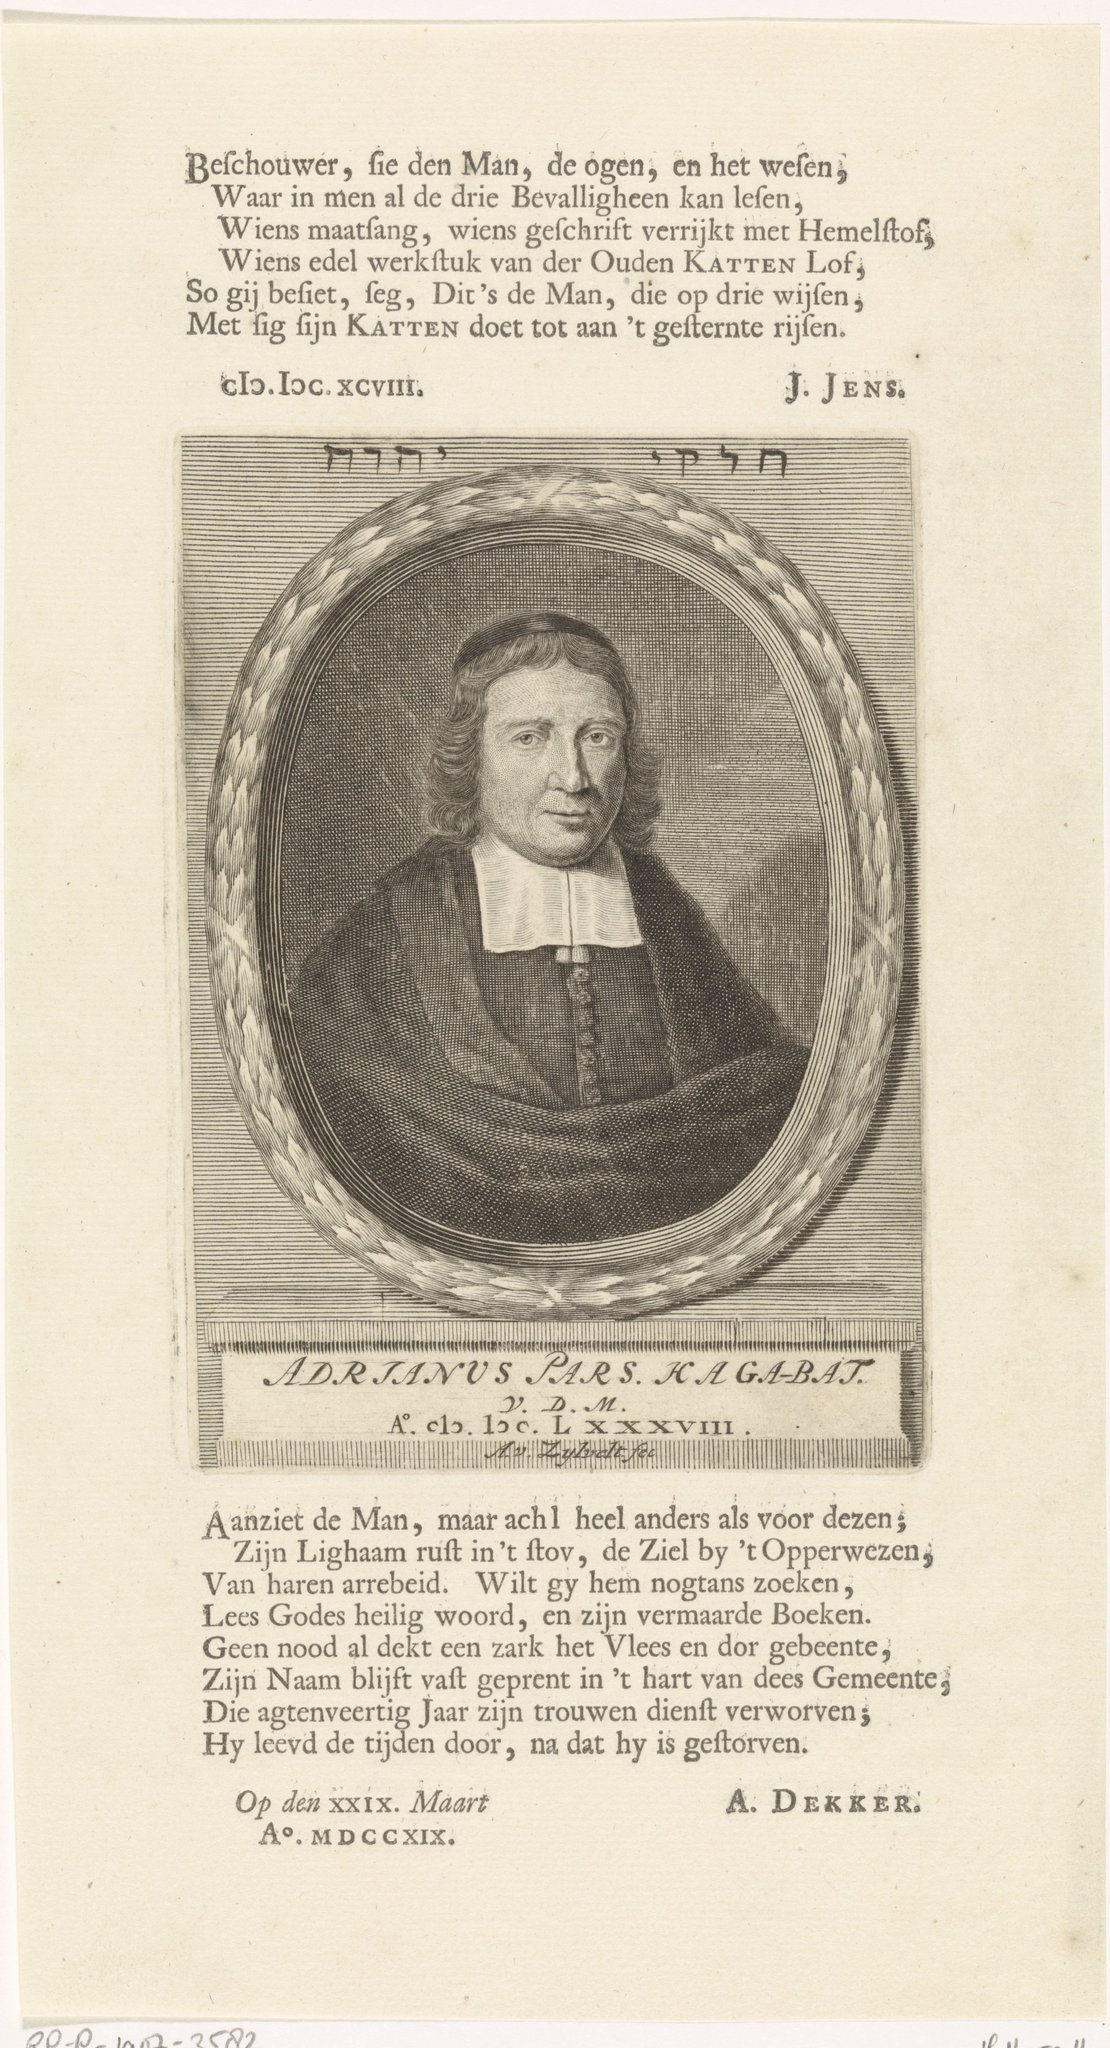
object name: print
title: Portret van Adriaan Pars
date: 1688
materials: paper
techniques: engraving, etching, letterpress printing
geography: amsterdam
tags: the hague, historical persons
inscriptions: collector's mark: Lugt 2228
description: Portret van Adriaan Pars, predikant te Katwijk, in een ovale lijst. Boven de lijst een tekst in het Hebreeuws.